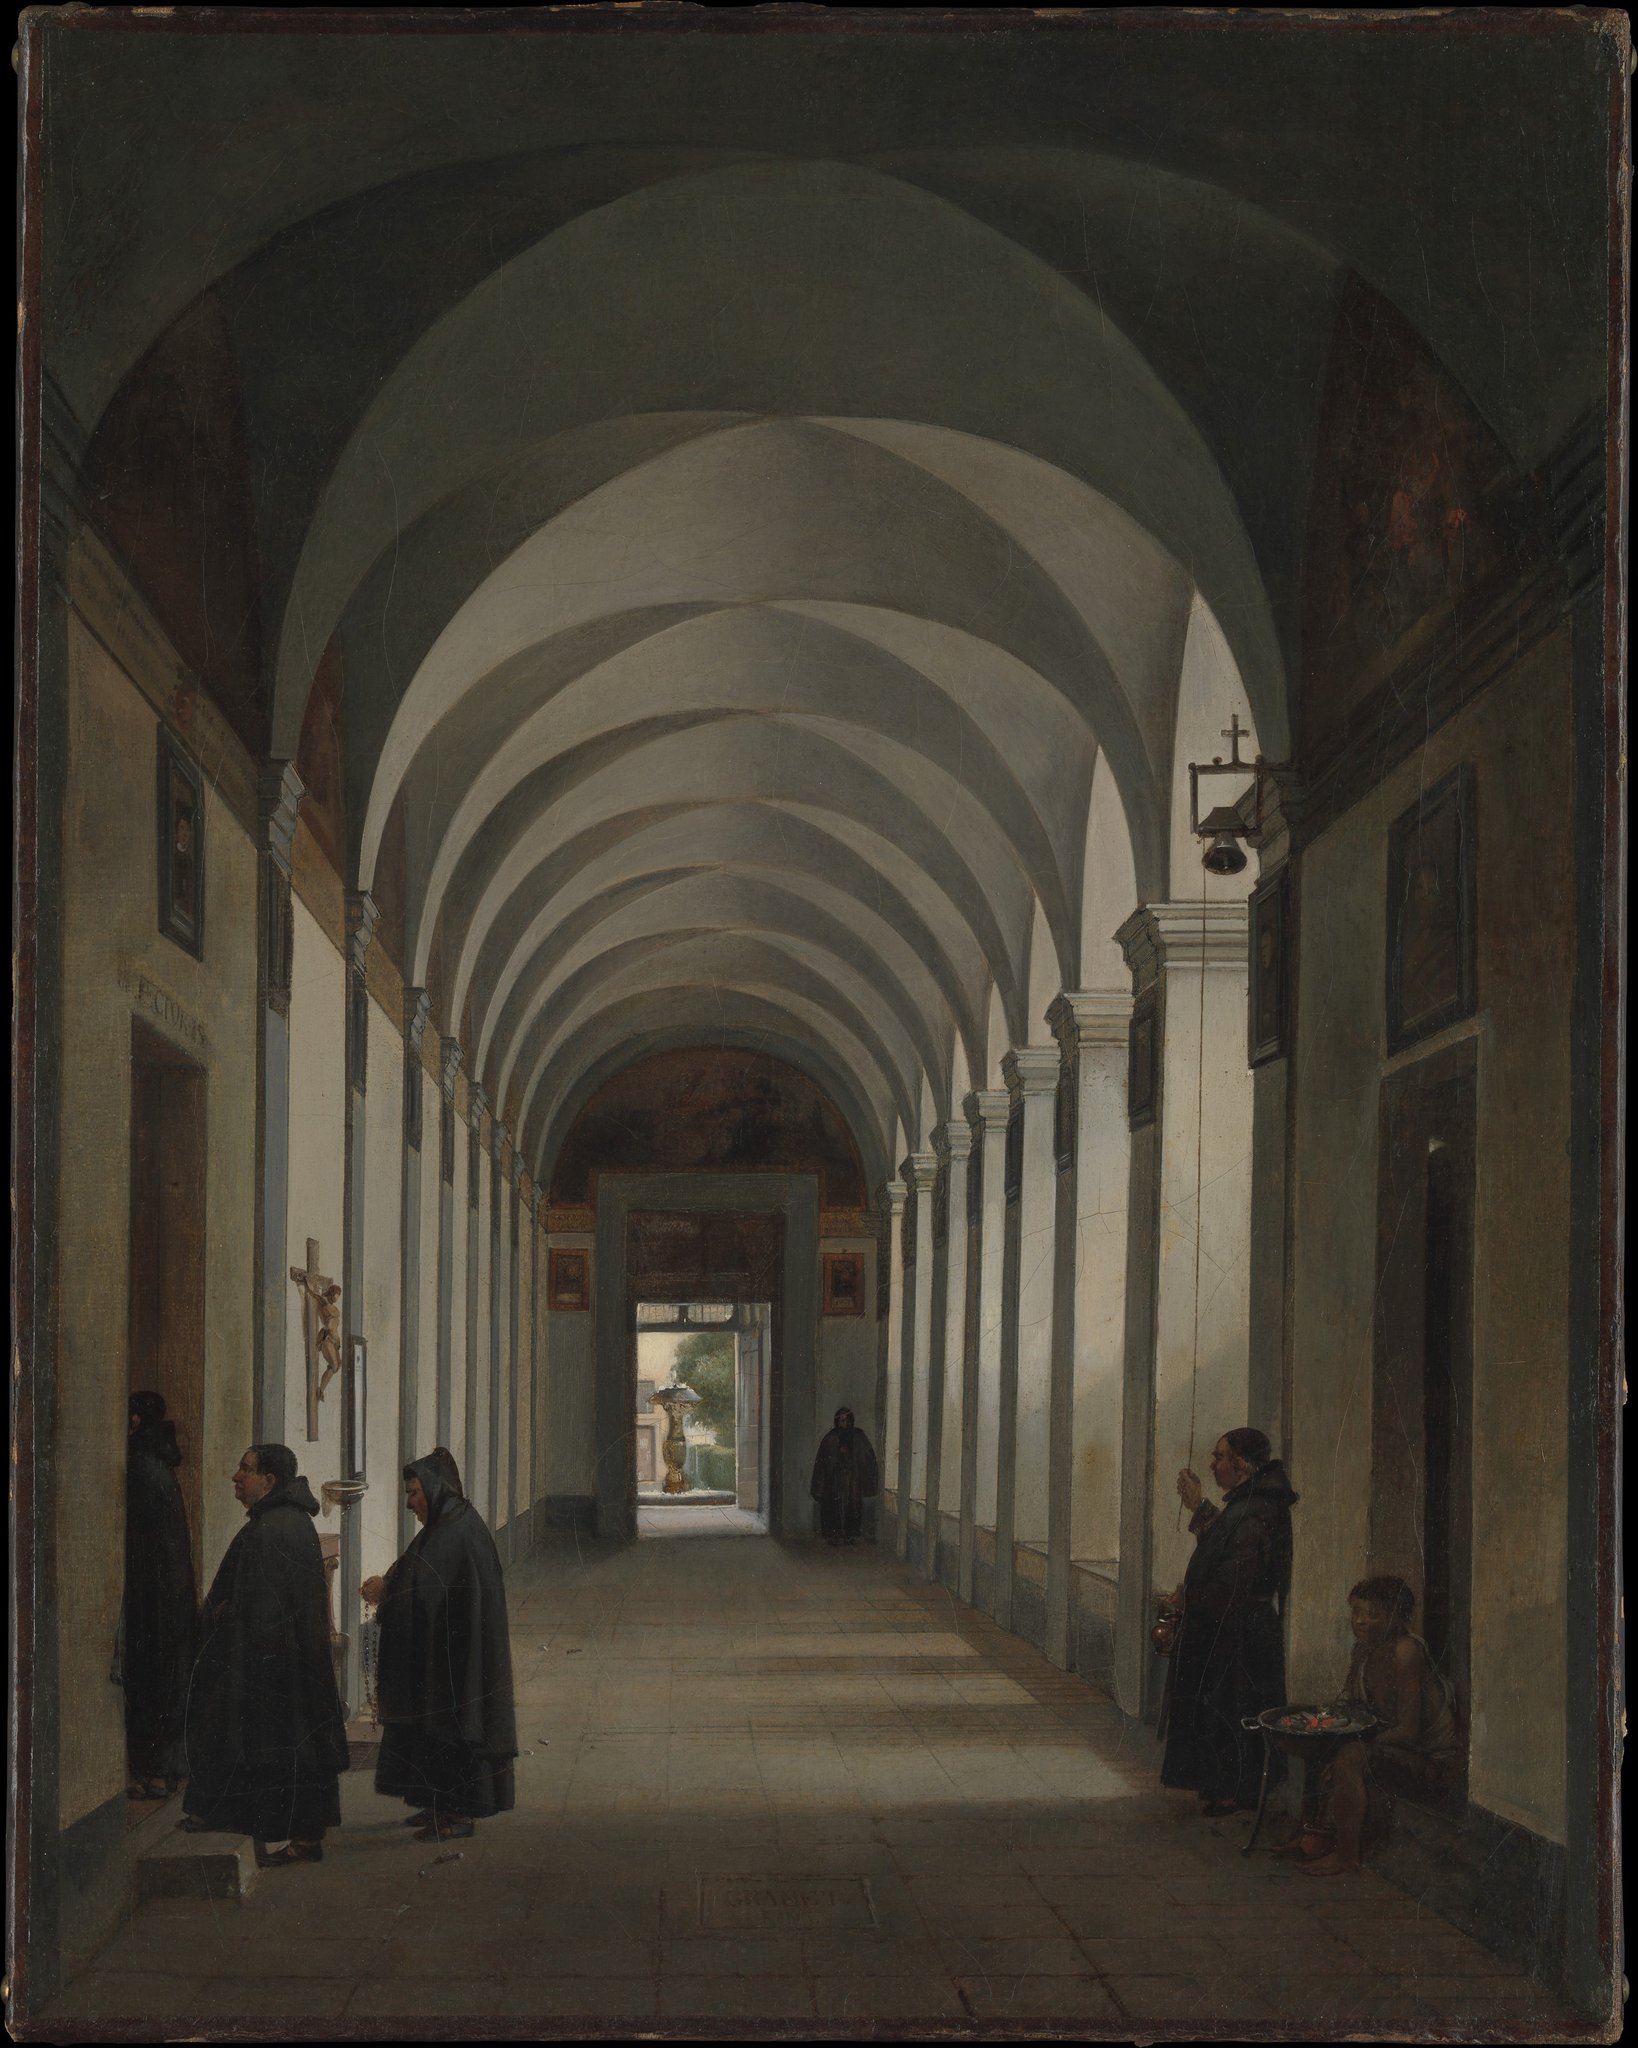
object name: painting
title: Monks in the Cloister of the Church of Gesù e Maria, Rome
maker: françois marius granet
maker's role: artist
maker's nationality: french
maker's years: 1775-1849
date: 1808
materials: canvas, oil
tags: cloisters,churches,monks,rome